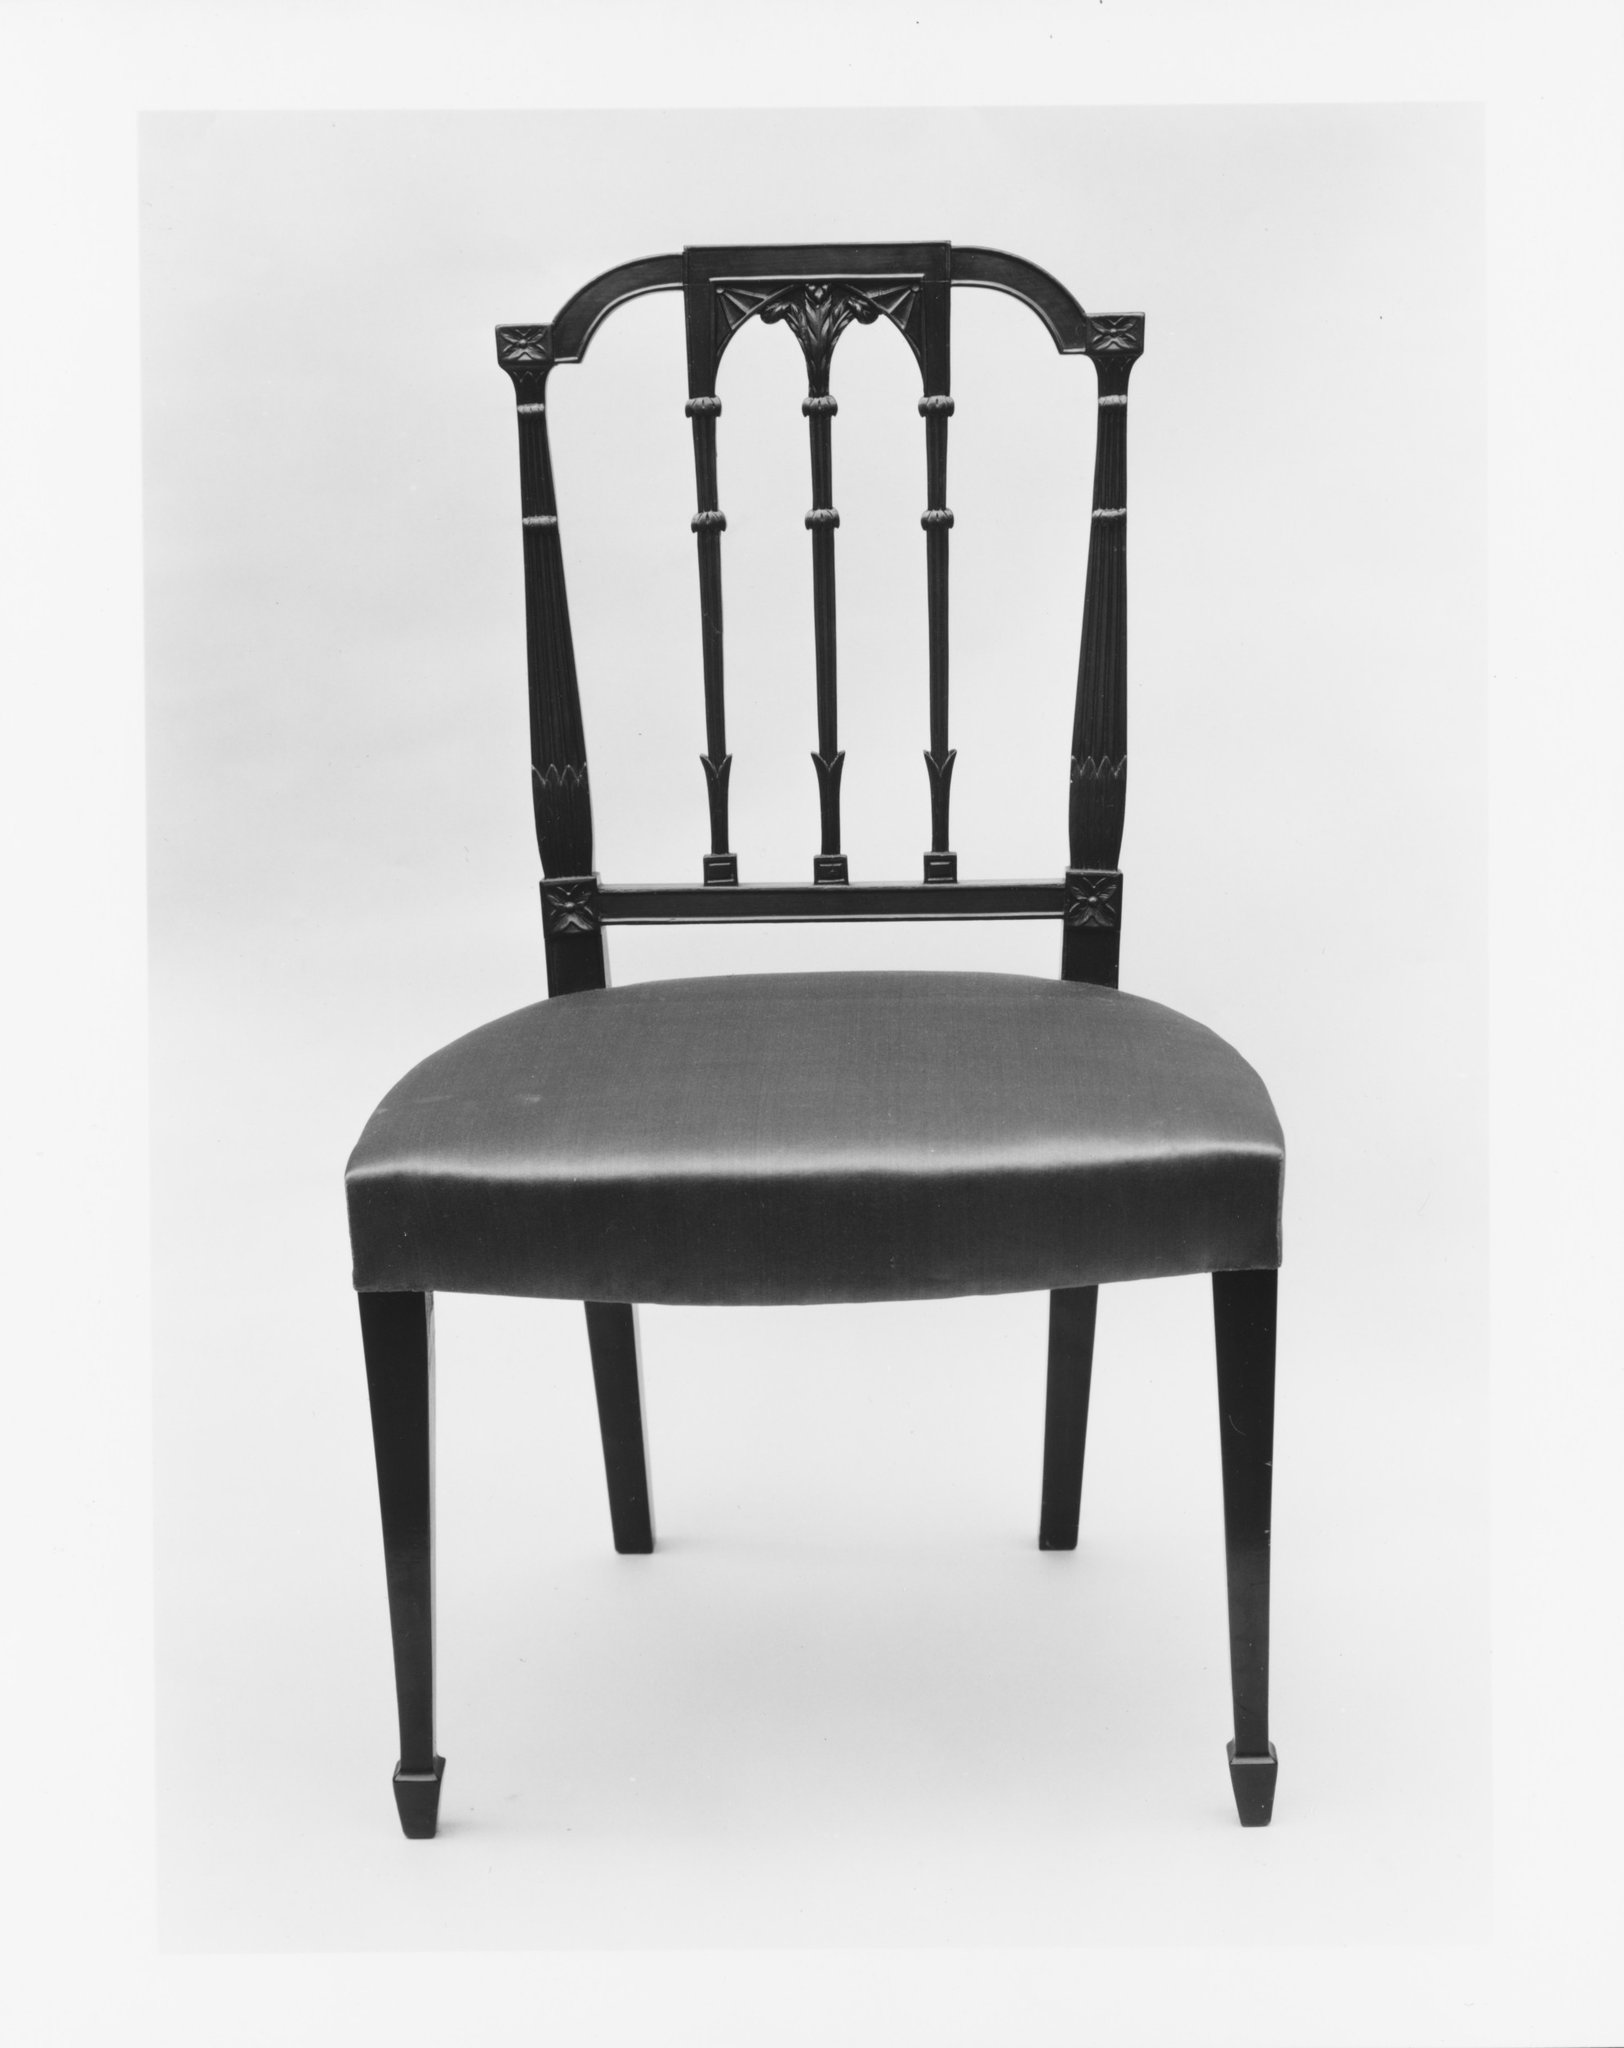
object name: side chair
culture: american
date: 1795-1810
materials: wood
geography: united states